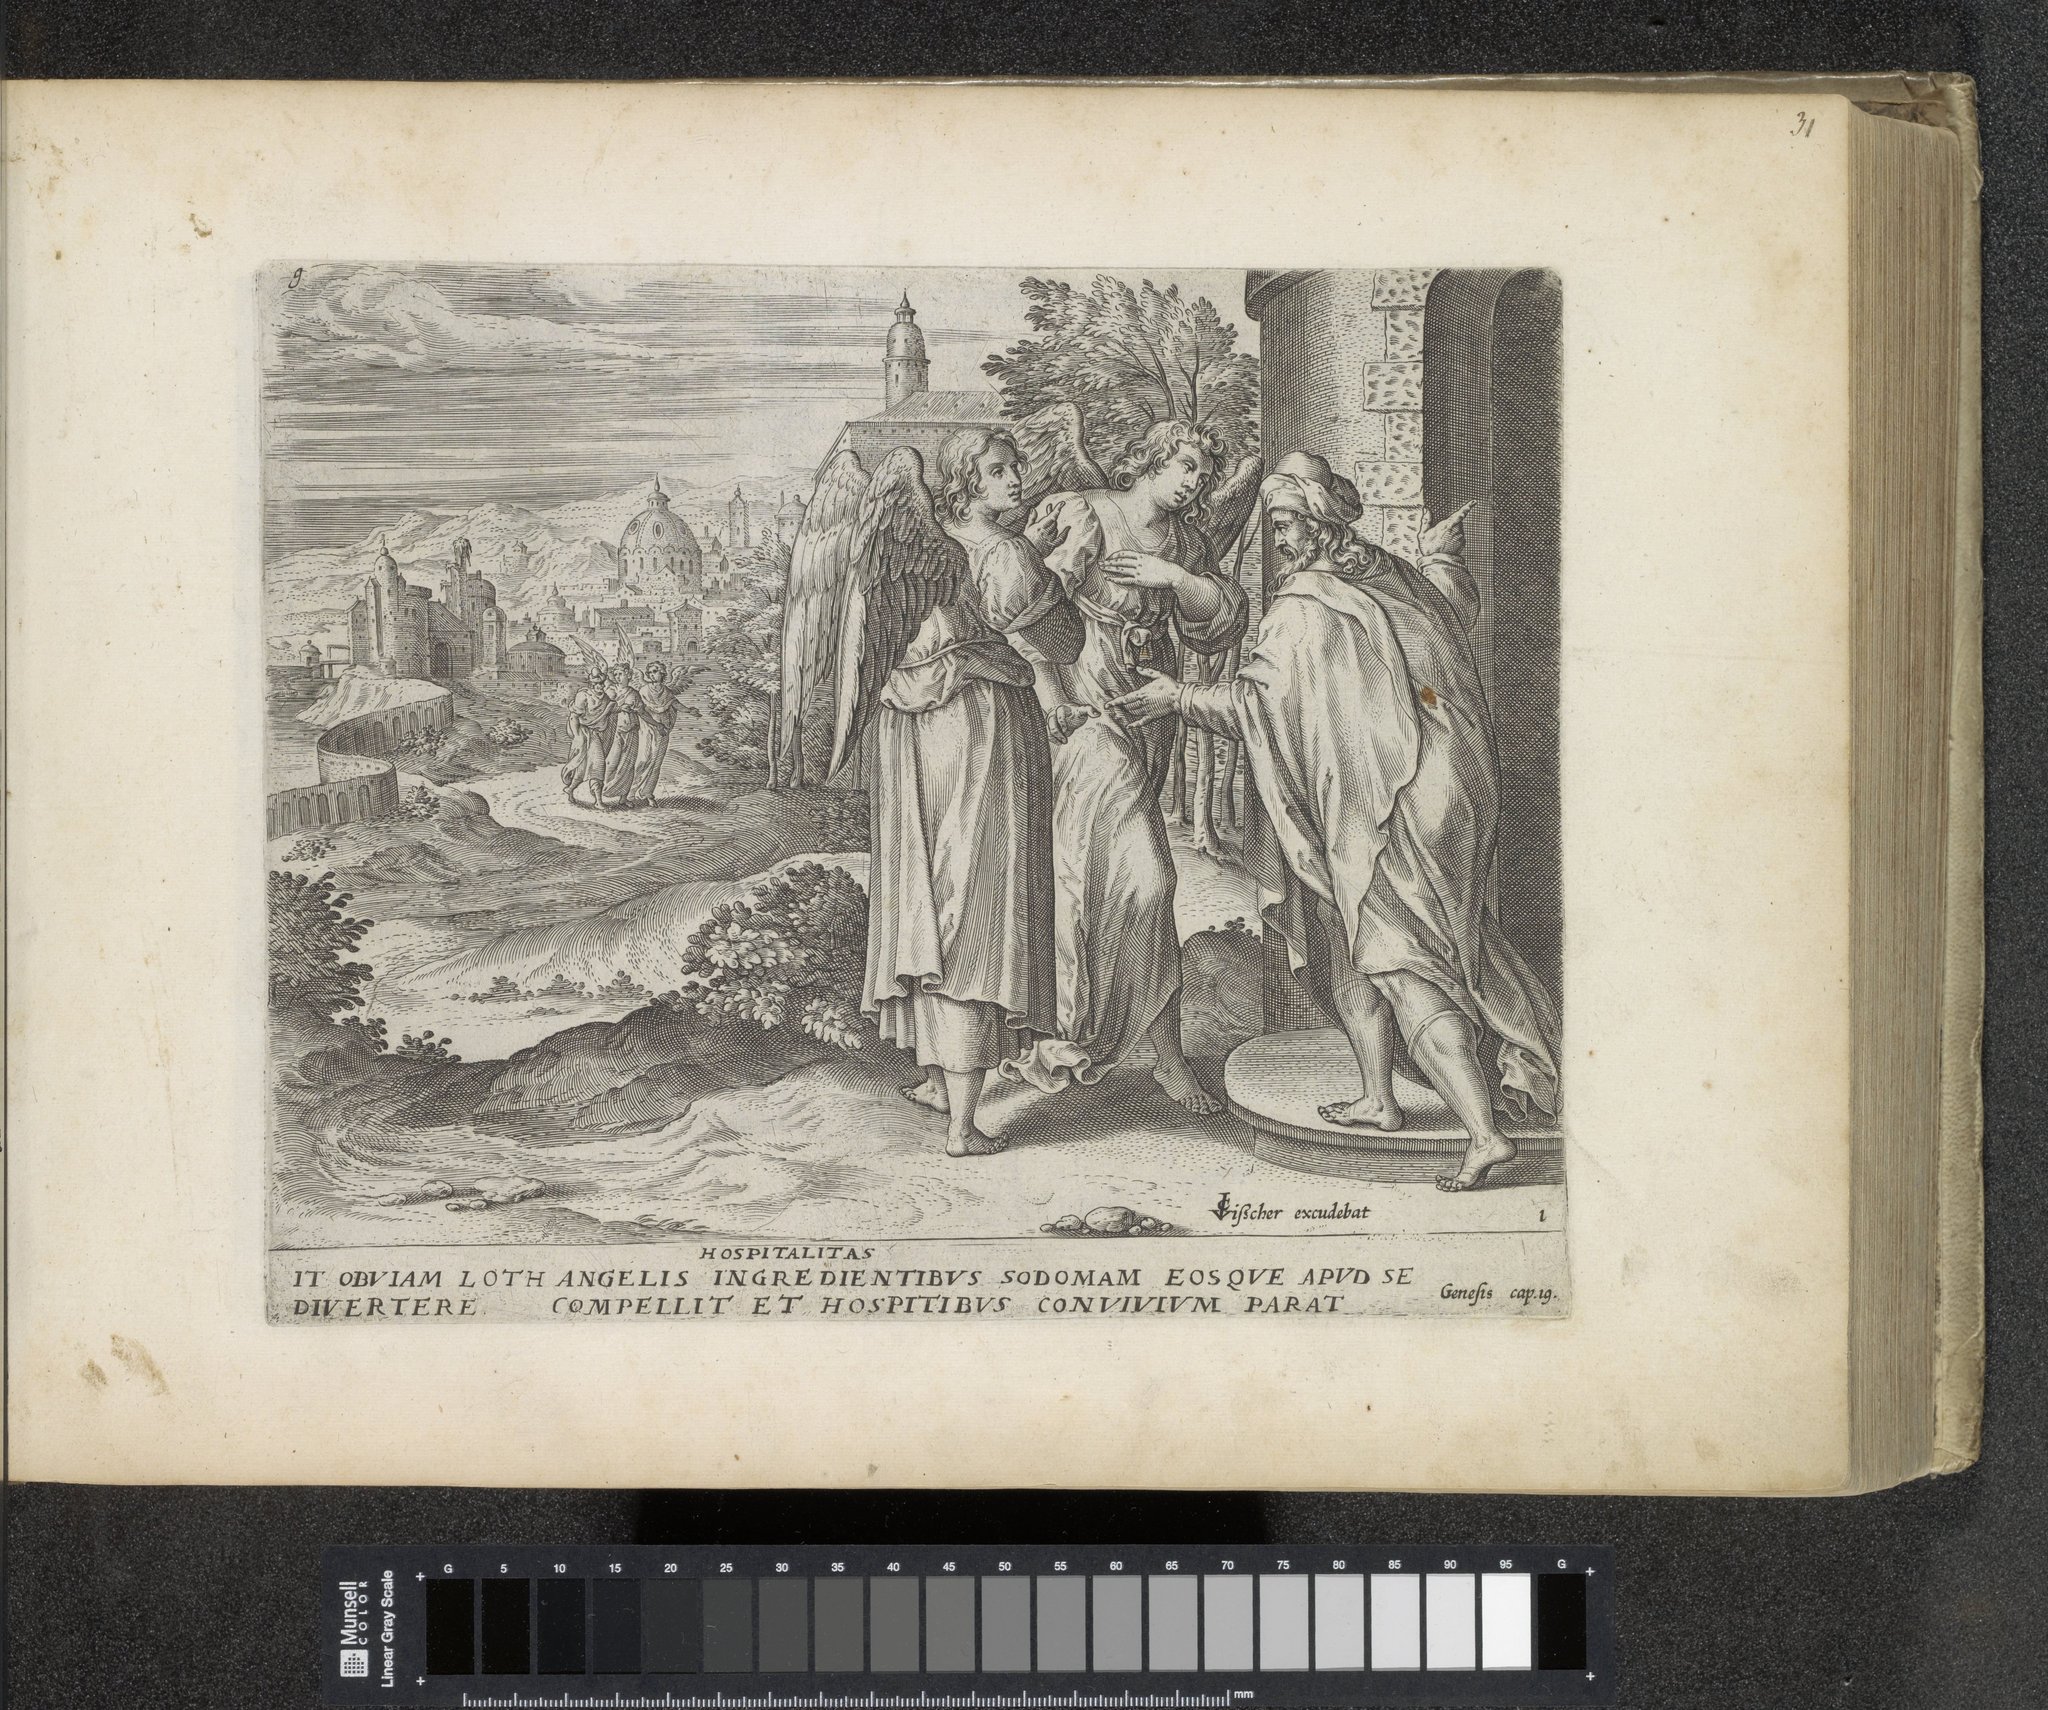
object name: print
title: Geschiedenis van Lot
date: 1579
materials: paper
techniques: engraving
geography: amsterdam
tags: lot and the two angels (genesis 19:1-23)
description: Lot nodigt de twee engelen uit voor de maaltijd en een overnachting bij hem thuis. Op de achtergrond is te zien wat aan deze scène vooraf ging: Lot loopt vanaf de stadspoort met de engelen naar zijn huis. Onder de voorstelling een verwijzing in het Latijn naar de Bijbeltekst in Gen. 19. Deze prent maakt deel uit van een album.